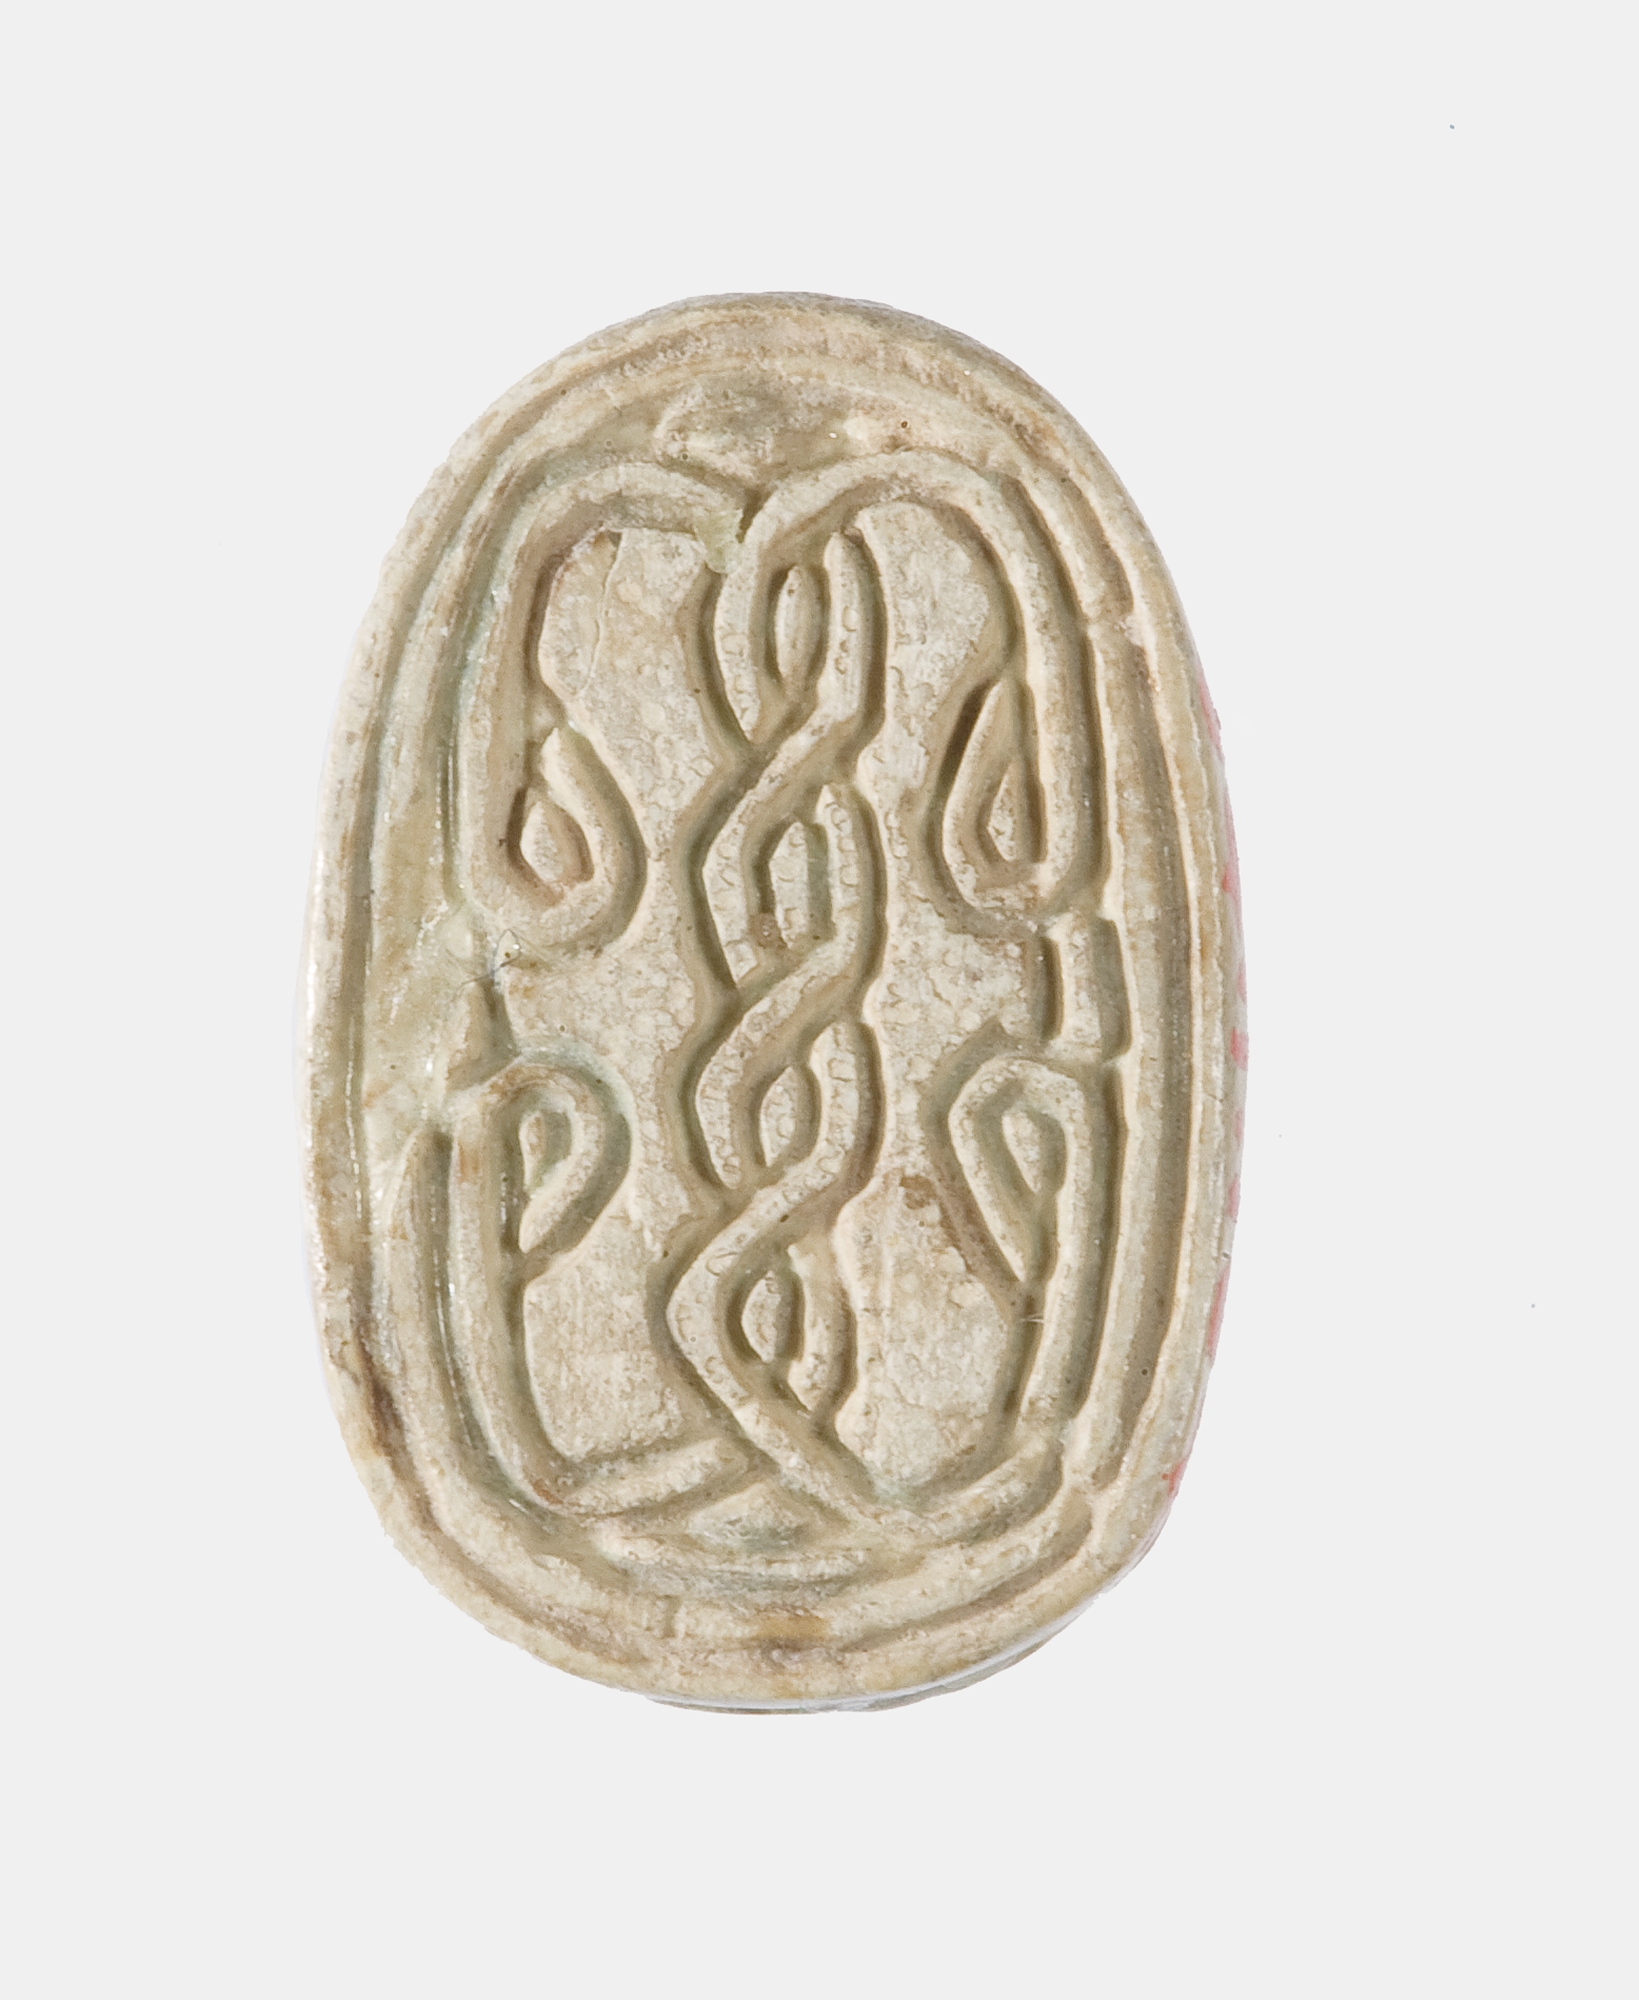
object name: scarab, coil, twist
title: Scarab with Coil Design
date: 1850-1640 BCE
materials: stone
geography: egypt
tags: scarabs